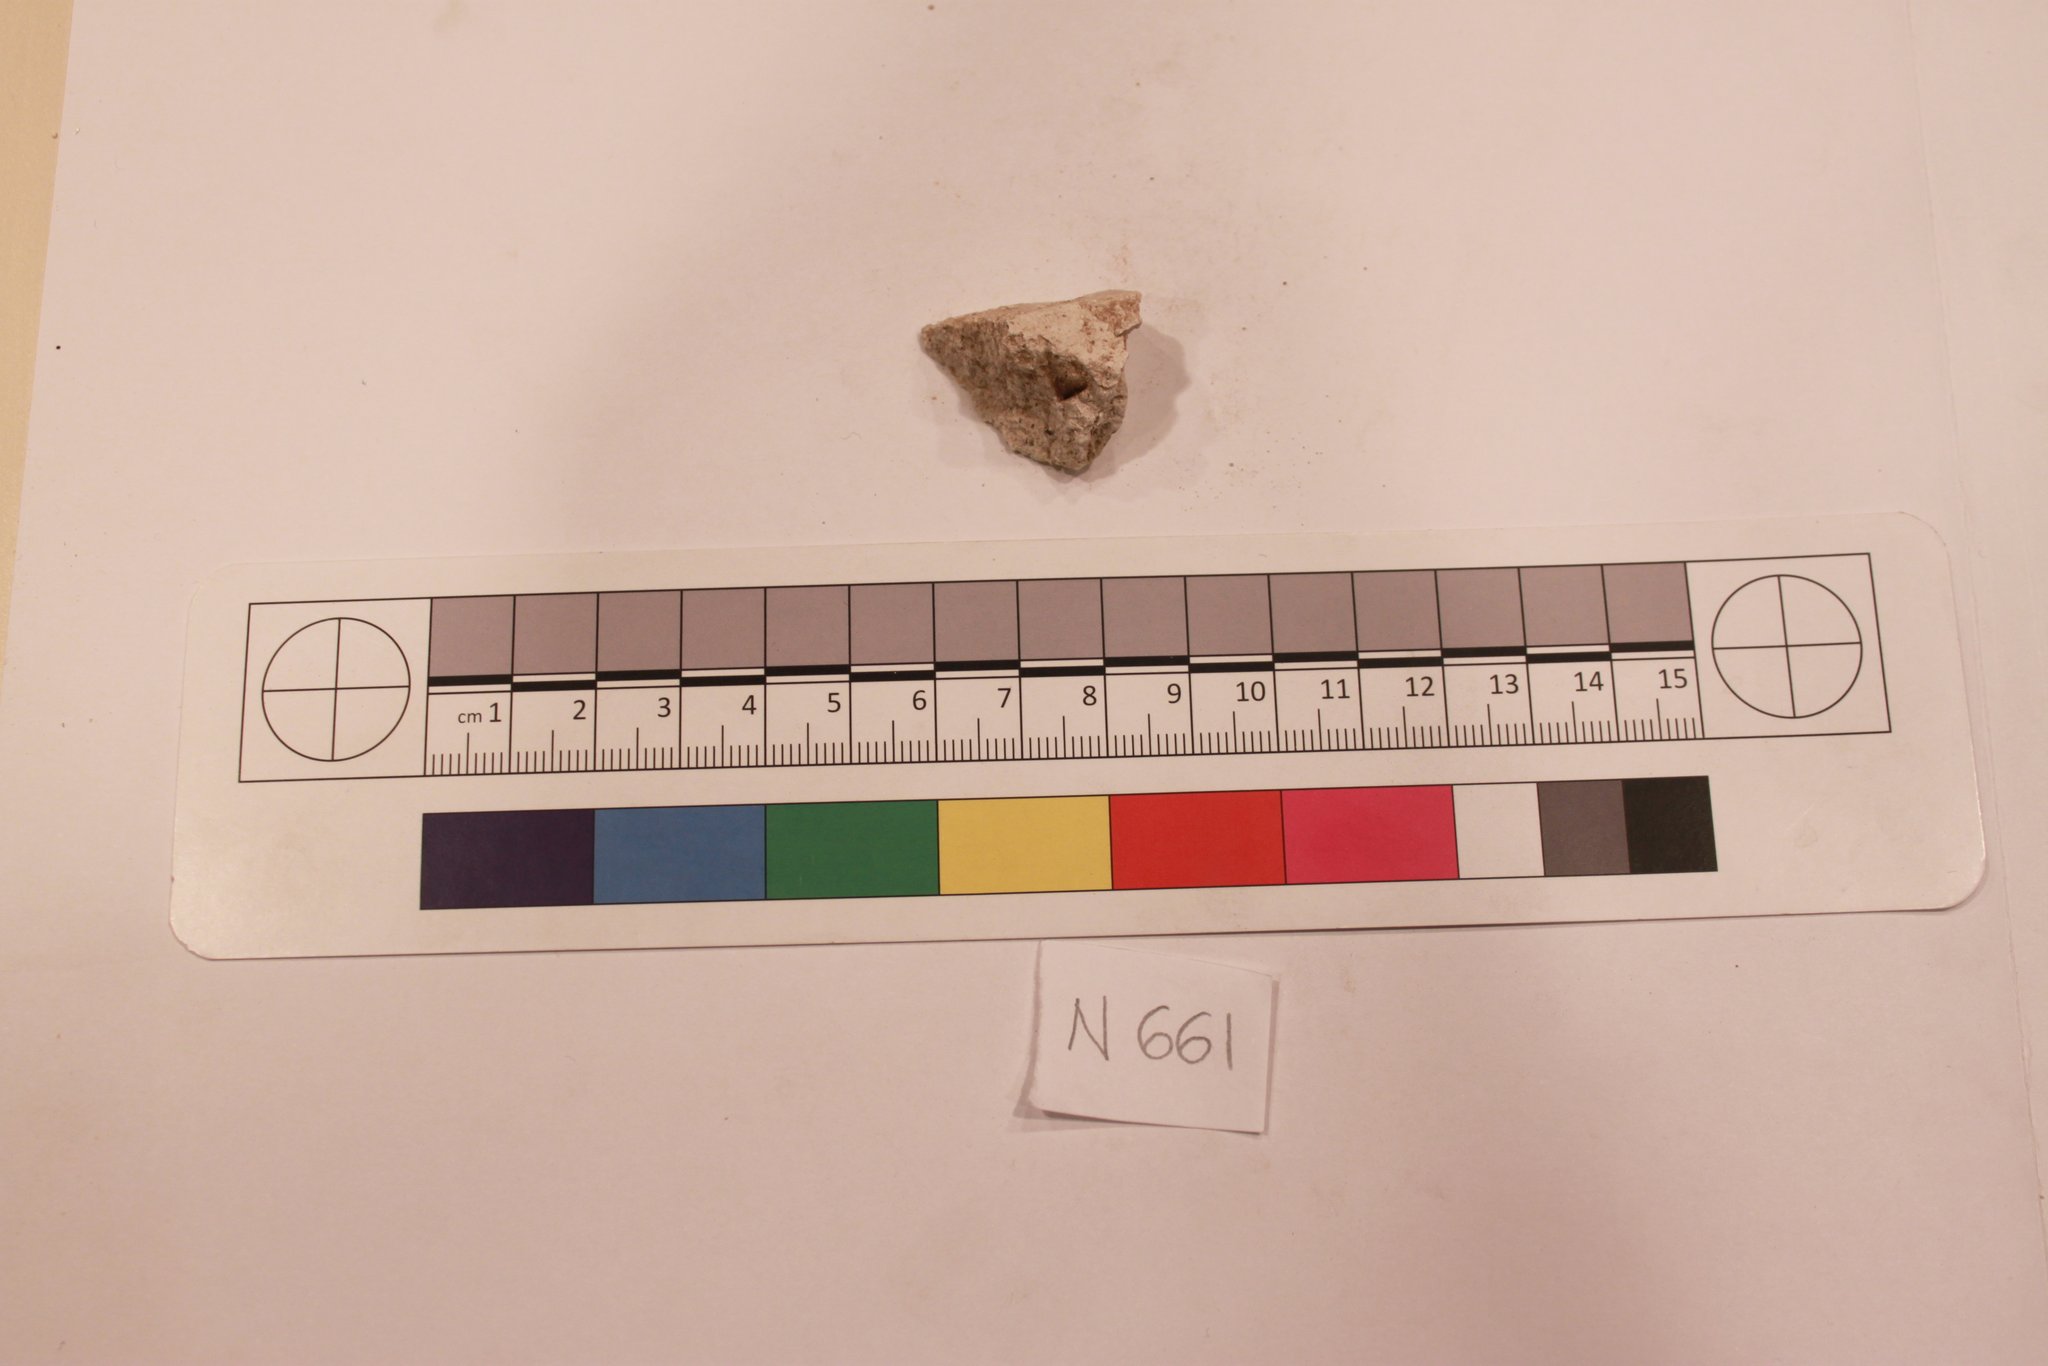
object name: fragment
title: Stucco Fragment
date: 701-1200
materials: plaster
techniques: carving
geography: iran